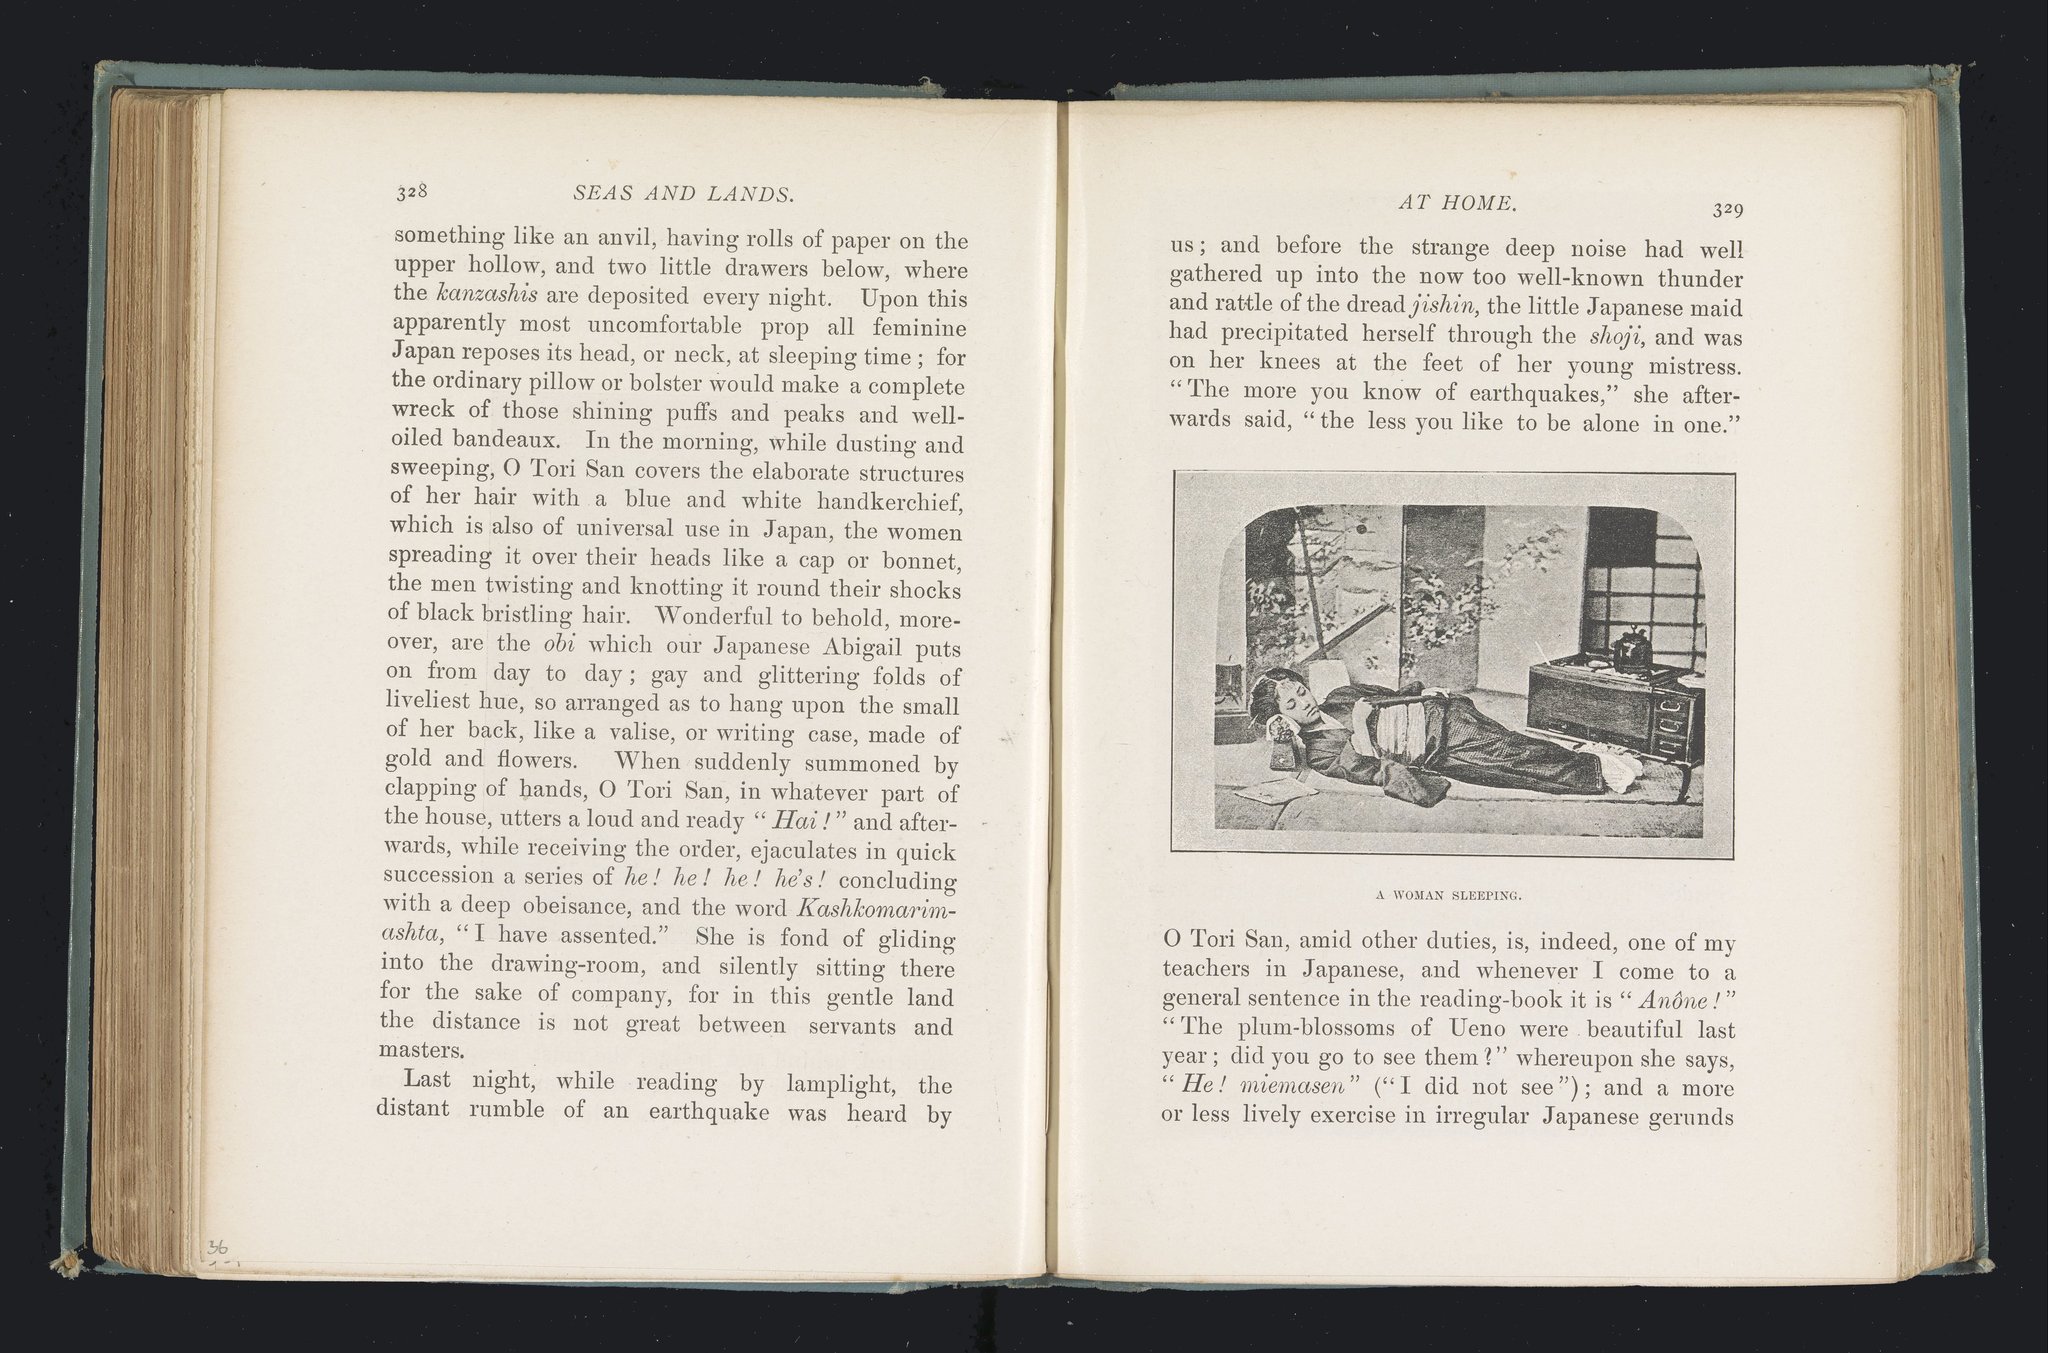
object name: photomechanical print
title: Portret van een onbekende liggende Japanse vrouw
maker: Anonymous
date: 1882-1892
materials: paper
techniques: autotype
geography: japan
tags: sleeping; unconsciousness